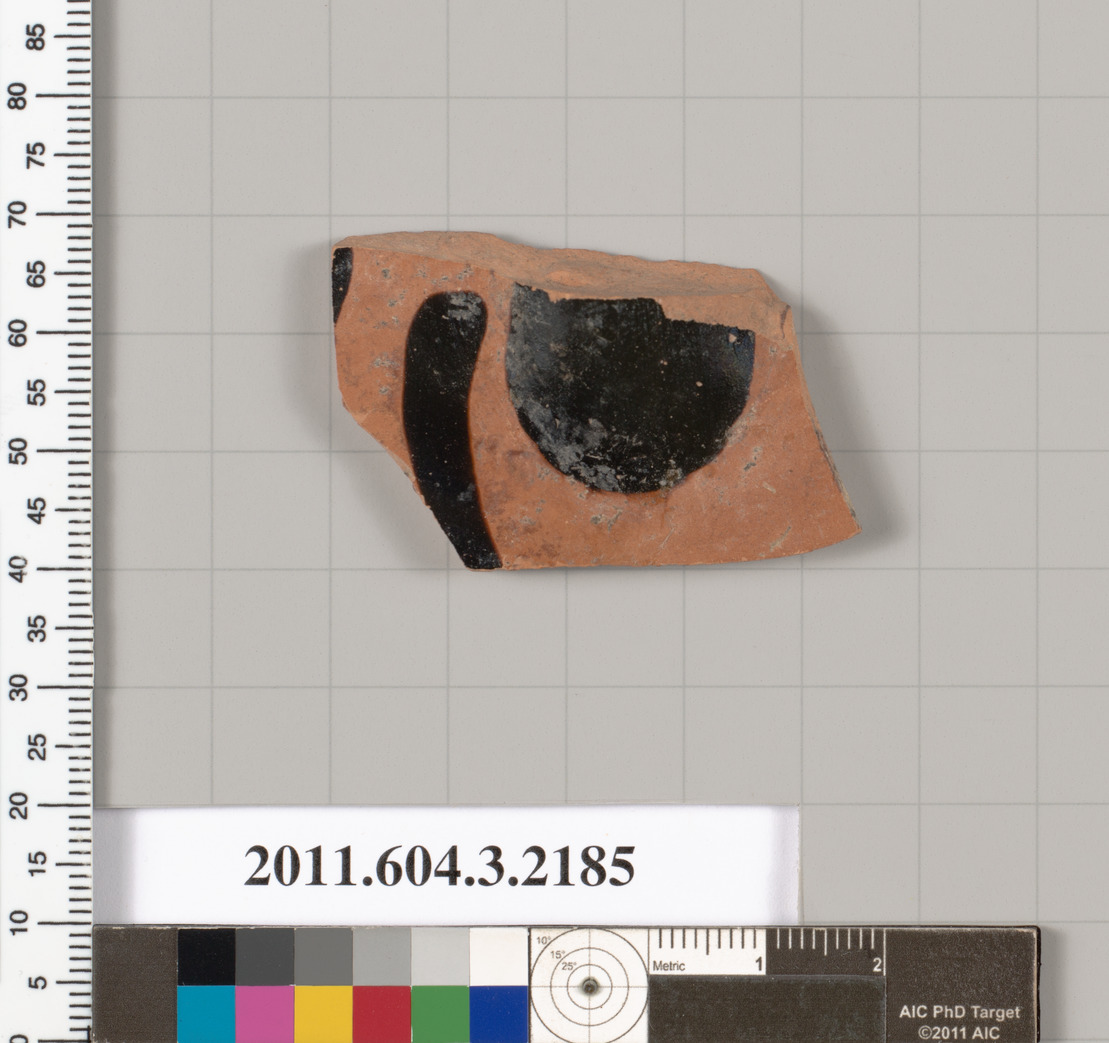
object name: kylix fragment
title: Terracotta fragment of a kylix (drinking cup)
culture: greek, attic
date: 500-468 BCE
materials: terracotta